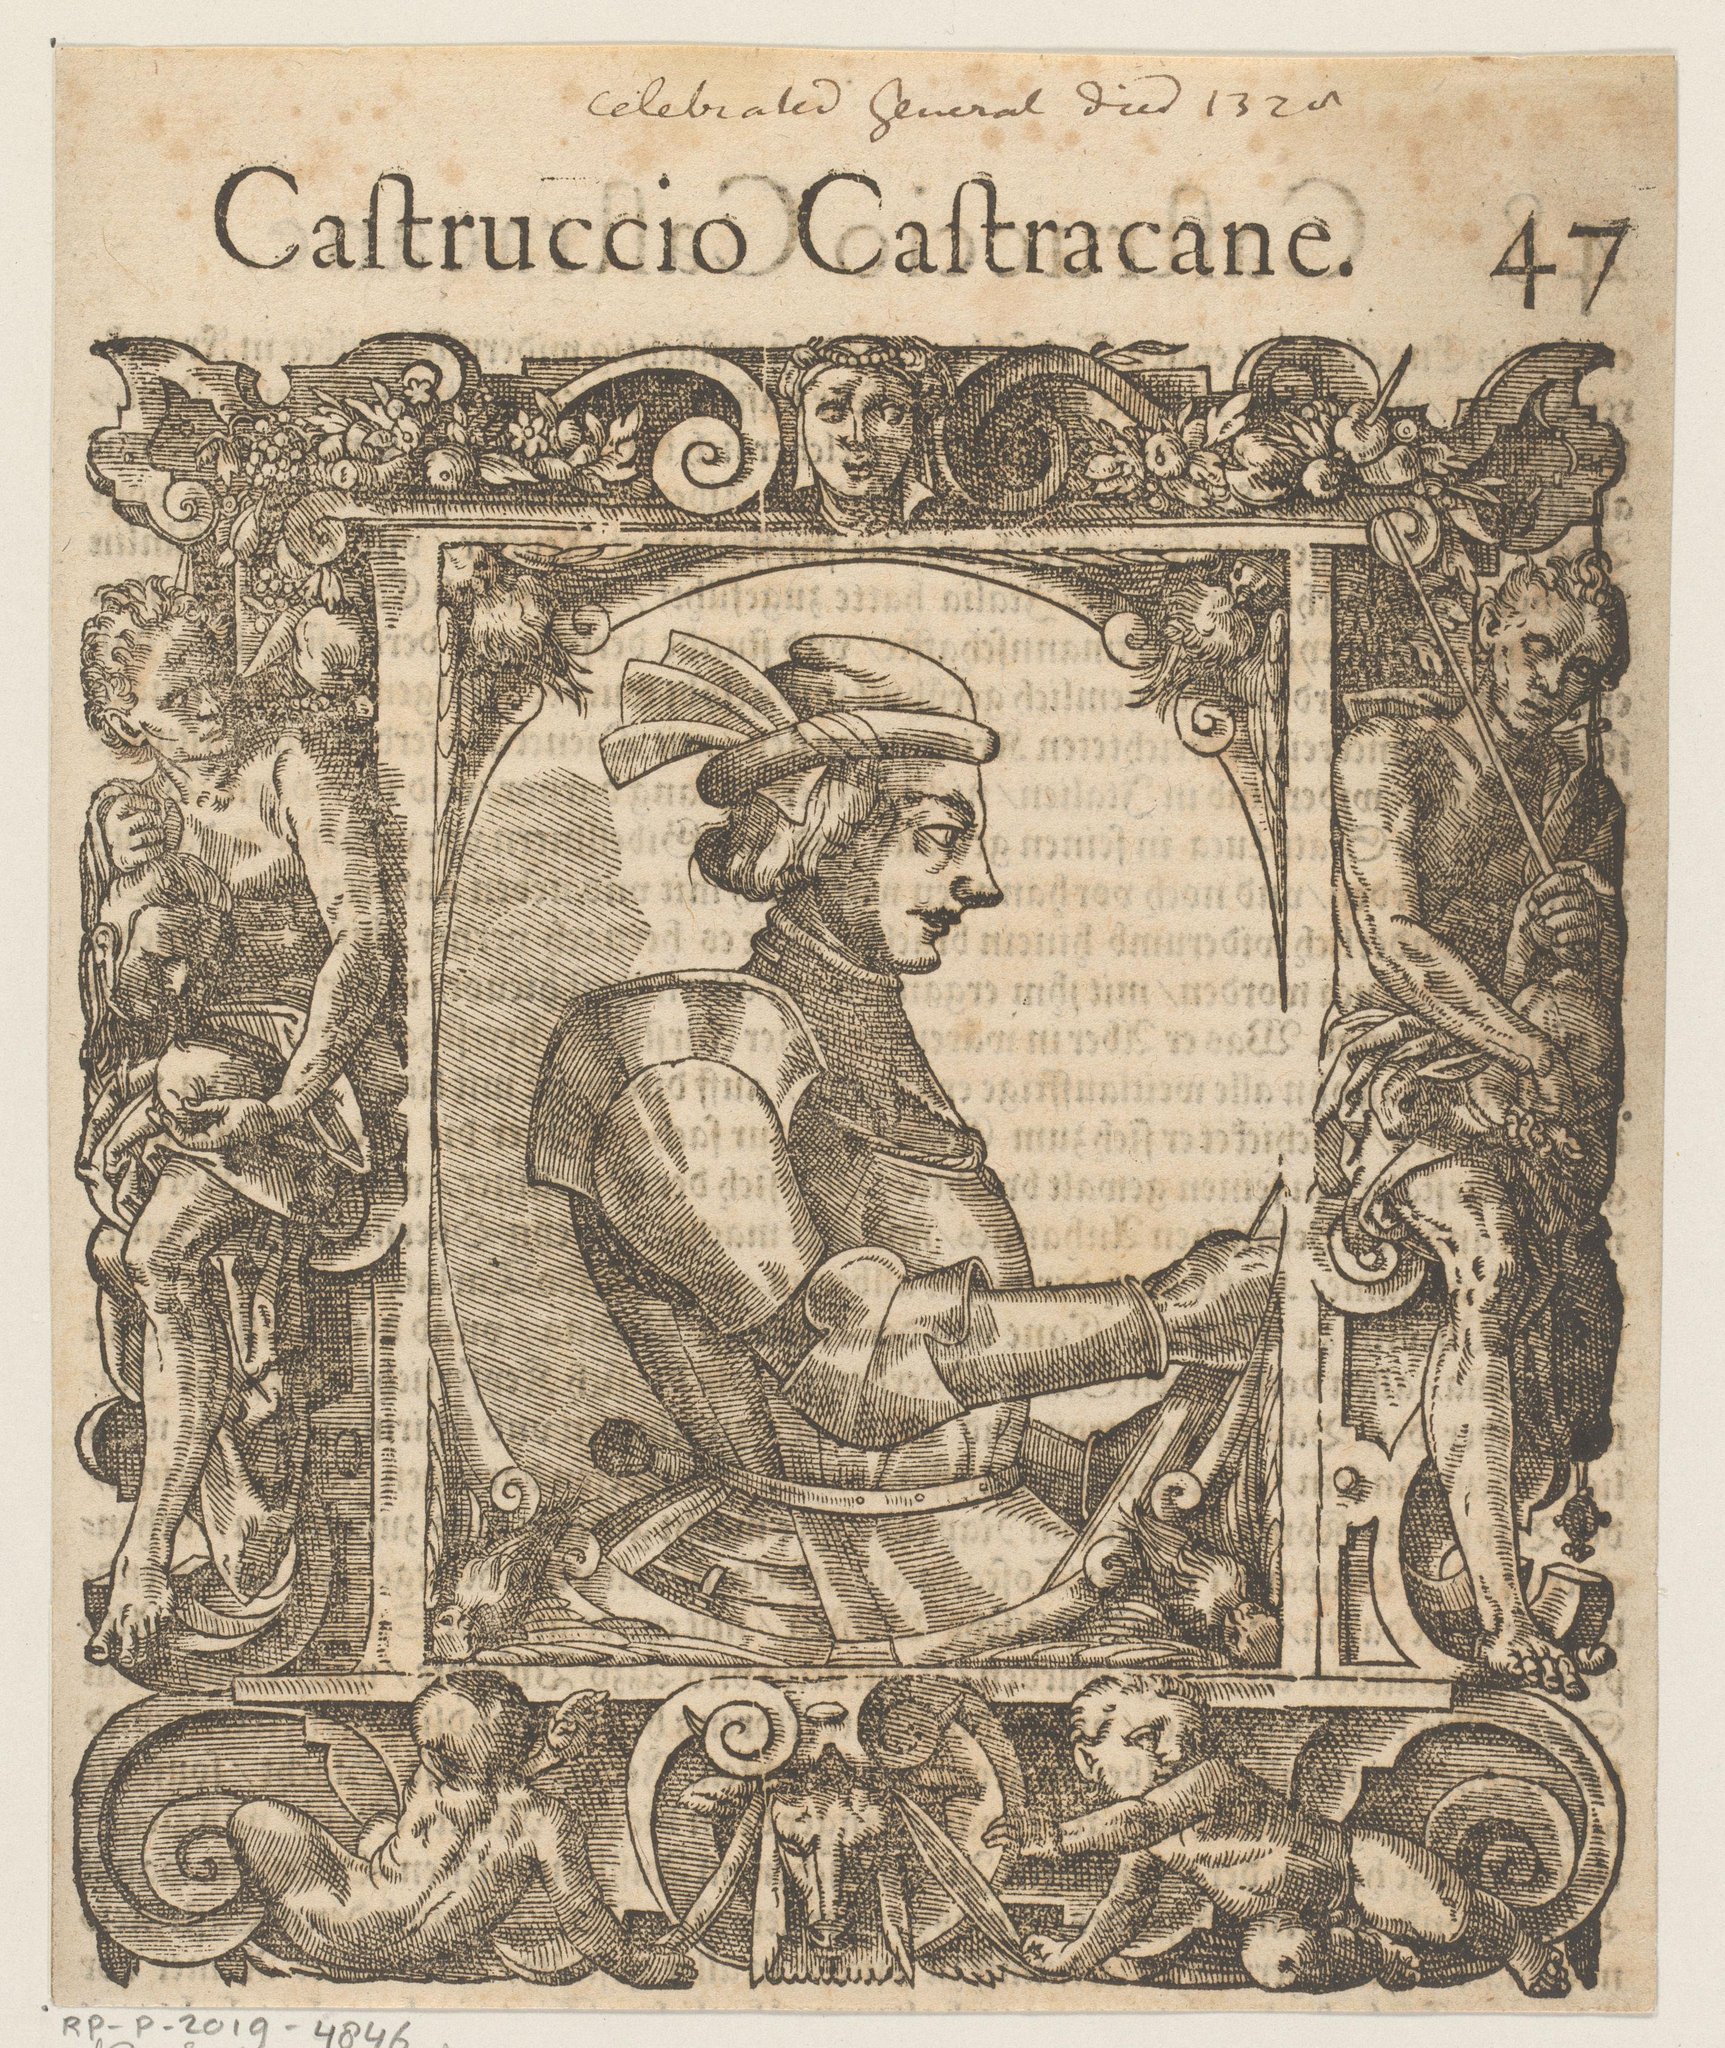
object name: print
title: Portret van Castruccio Castracani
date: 1587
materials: paper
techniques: letterpress printing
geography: basel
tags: armour, historical persons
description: Prent uit: Warhafftiger kurtzer Bericht von mannigerley Kriegs und anderen fürnemen (...). Bazel: Konrad Waldkirch, 1587, p. 47. Prent eerder verschenen in: Giovio, Paolo. Elogia virorum bellica virtute illustrium (...). Bazel: Peter Perna, 1575. Prent mogelijk ook gebruikt in latere publicaties.